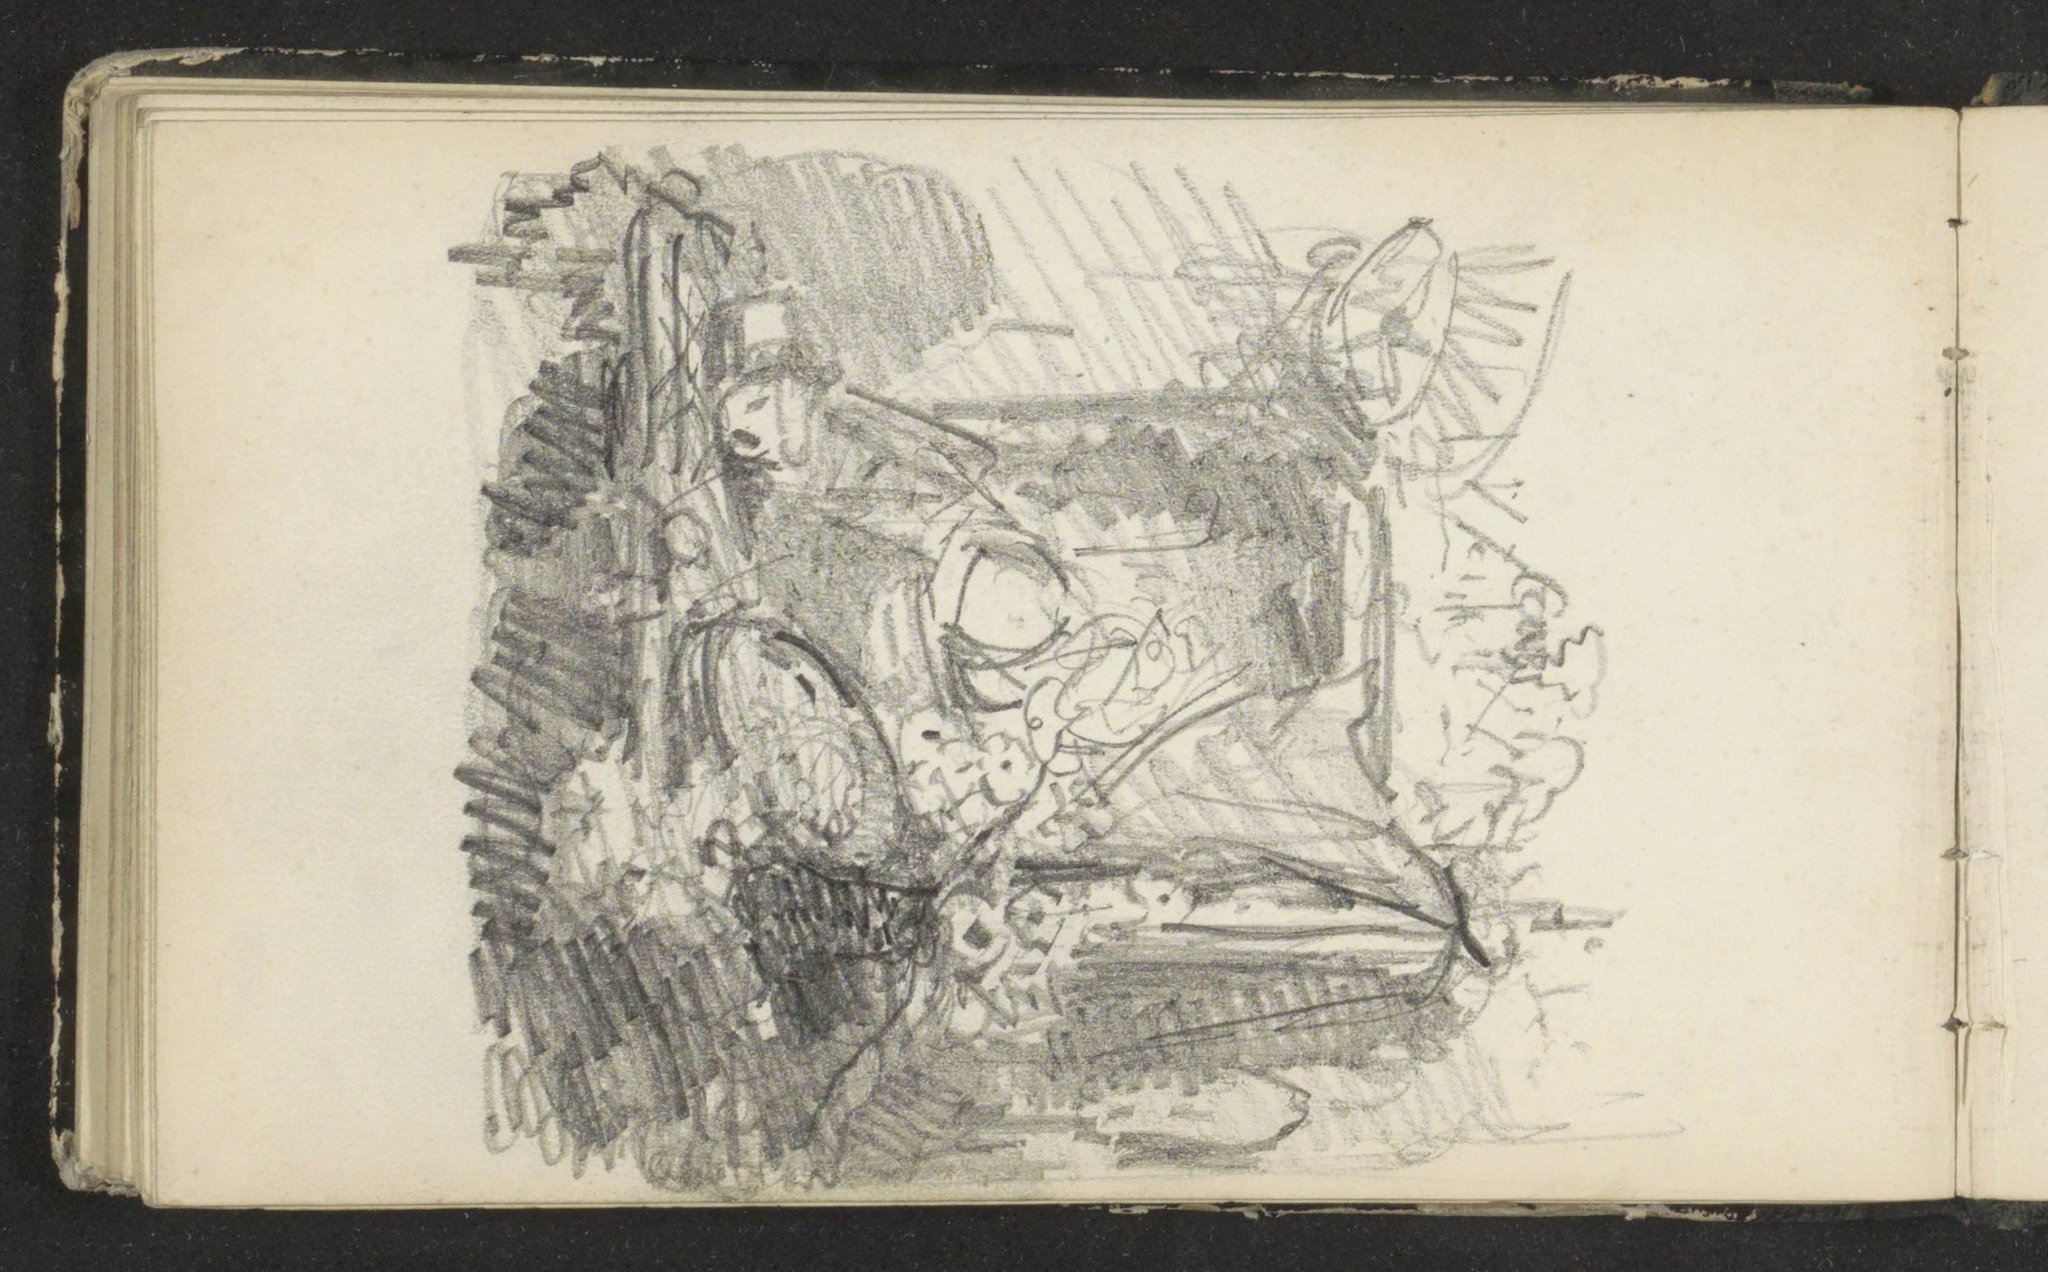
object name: sketchbook leaf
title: Stilleven met schalen en kommen op een tafel bij een nis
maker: maria vos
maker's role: draughtsman, painter, print maker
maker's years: 1824-1906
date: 1834-1906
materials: paper, pencil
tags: still life of related objects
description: Blad 46 verso uit een schetsboek met 46 bladen.